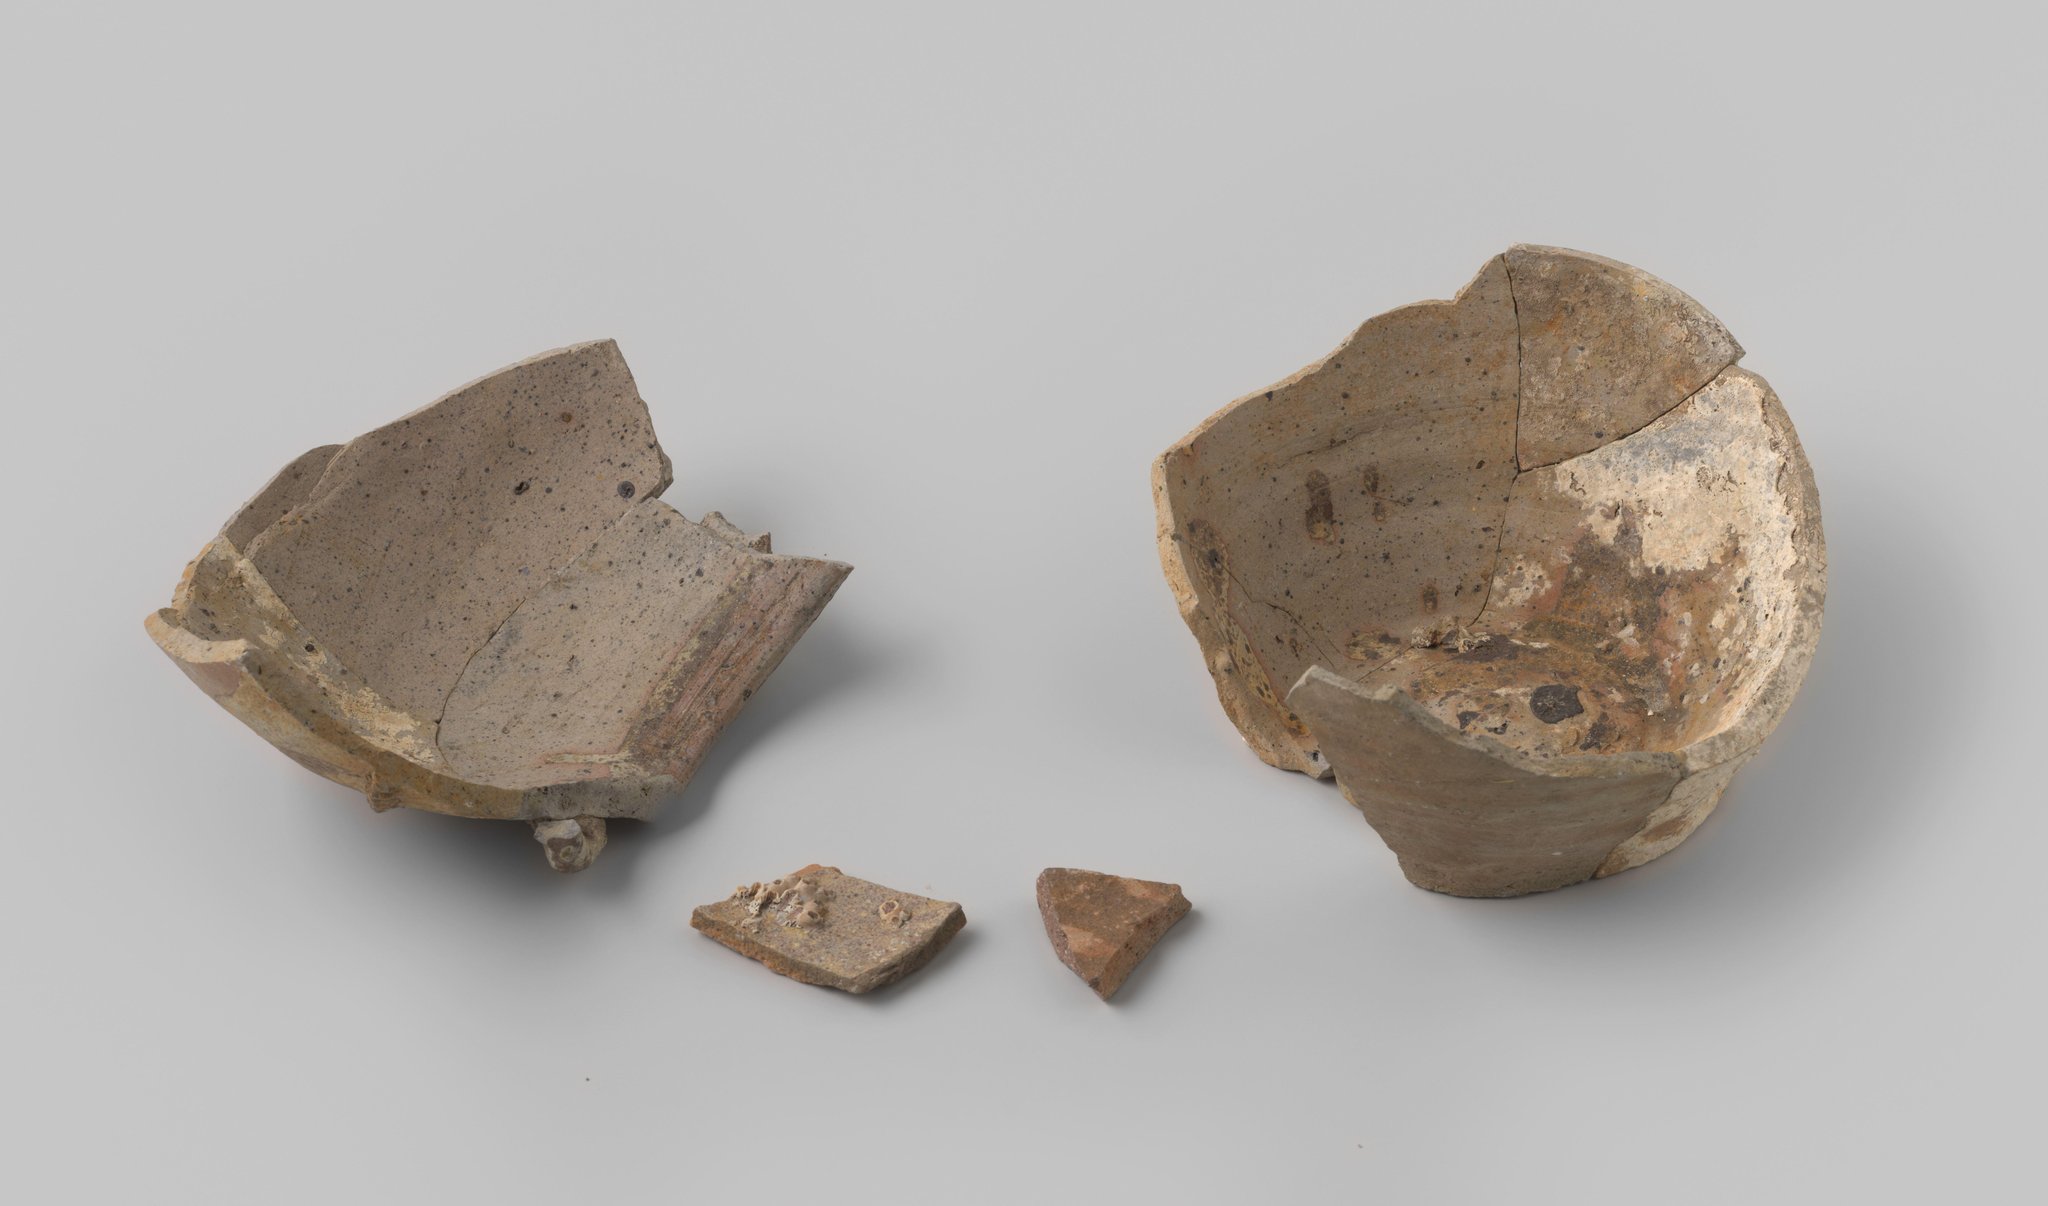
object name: martavaan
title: Scherven uit V.O.C.-schip de 'Witte Leeuw'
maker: Anonymous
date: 1613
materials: porcelain, stoneware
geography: southeast asia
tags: verenigde oostindische compagnie, sint-helena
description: Scherven uit V.O.C.-schip de 'Witte Leeuw'. Eén bestaande uit vijf aan elkaar gelijmde fragmenten, één uit drie aan elkaar gelijmde fragmenten.